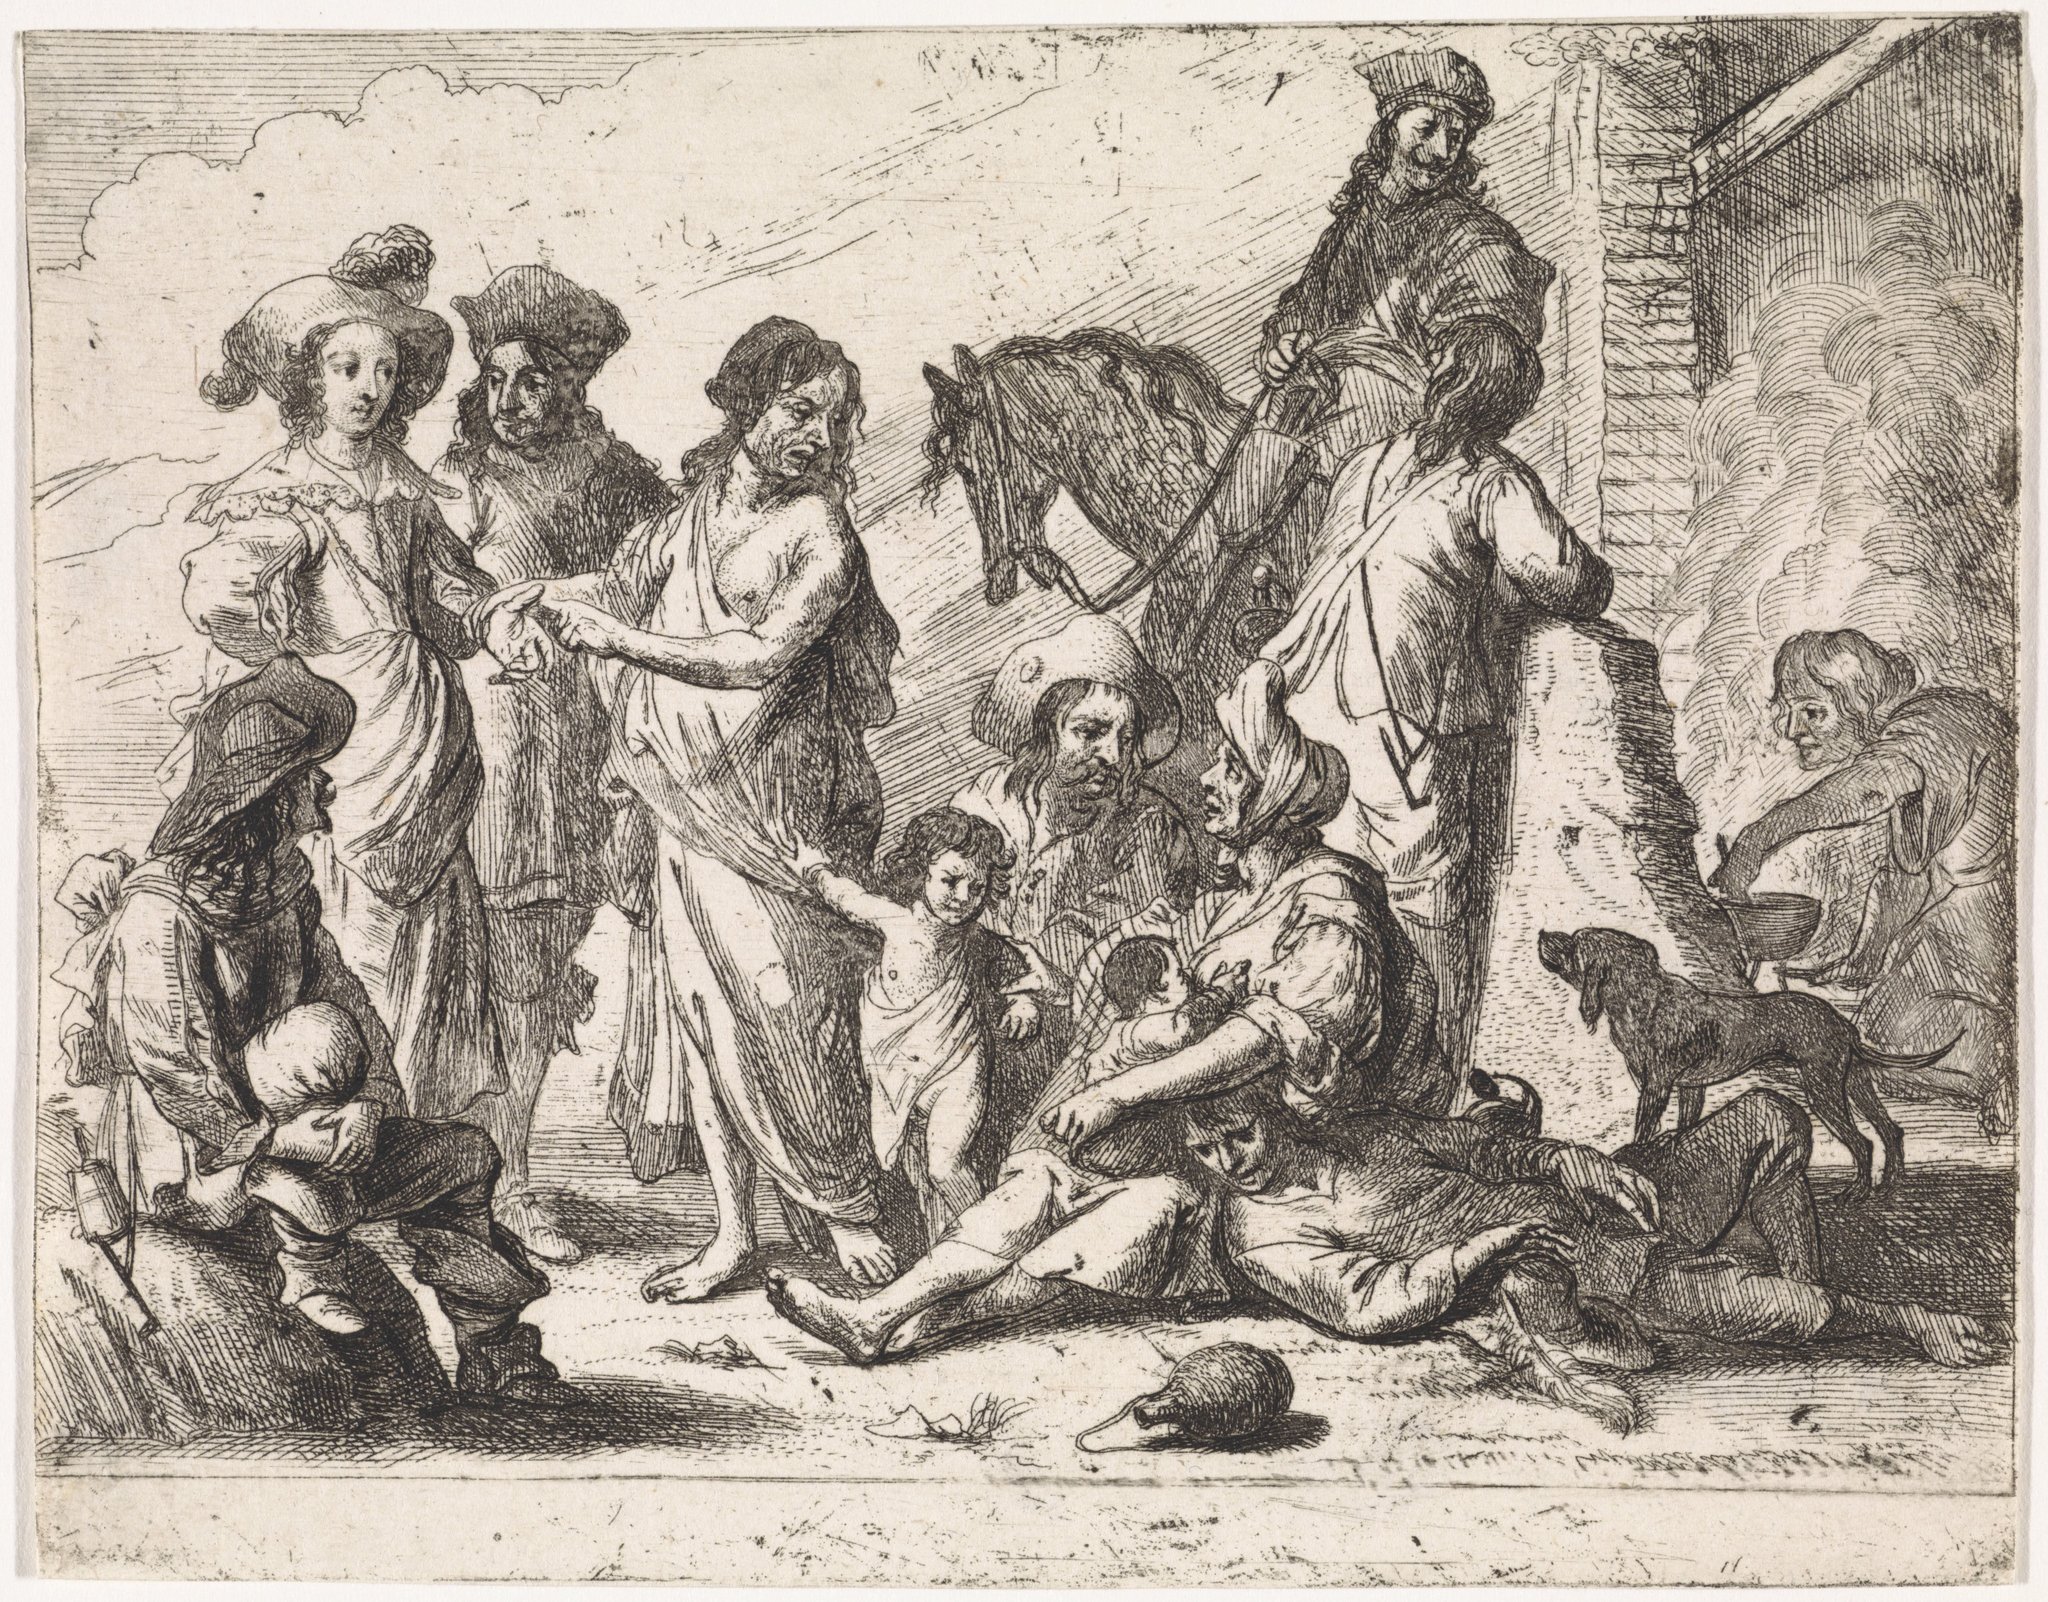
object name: print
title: Genretaferelen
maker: cornelis de wael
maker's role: draughtsman, print maker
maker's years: 1592-1667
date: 1630-1648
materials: paper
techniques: engraving, etching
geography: italy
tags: nursing, suckling, contrast between rich and poor, fortune-teller ~ pleasure fair and circus, kitchen-utensils: pot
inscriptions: collector's mark: Lugt 2228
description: Te midden van boeren leest een in lompen gehulde waarzegster de hand van een rijkgeklede vrouw. De waarzegster kijkt om naar een boerin die haar kind de borst geeft. Rechts bij een muur roert een vrouw in een kookpot.